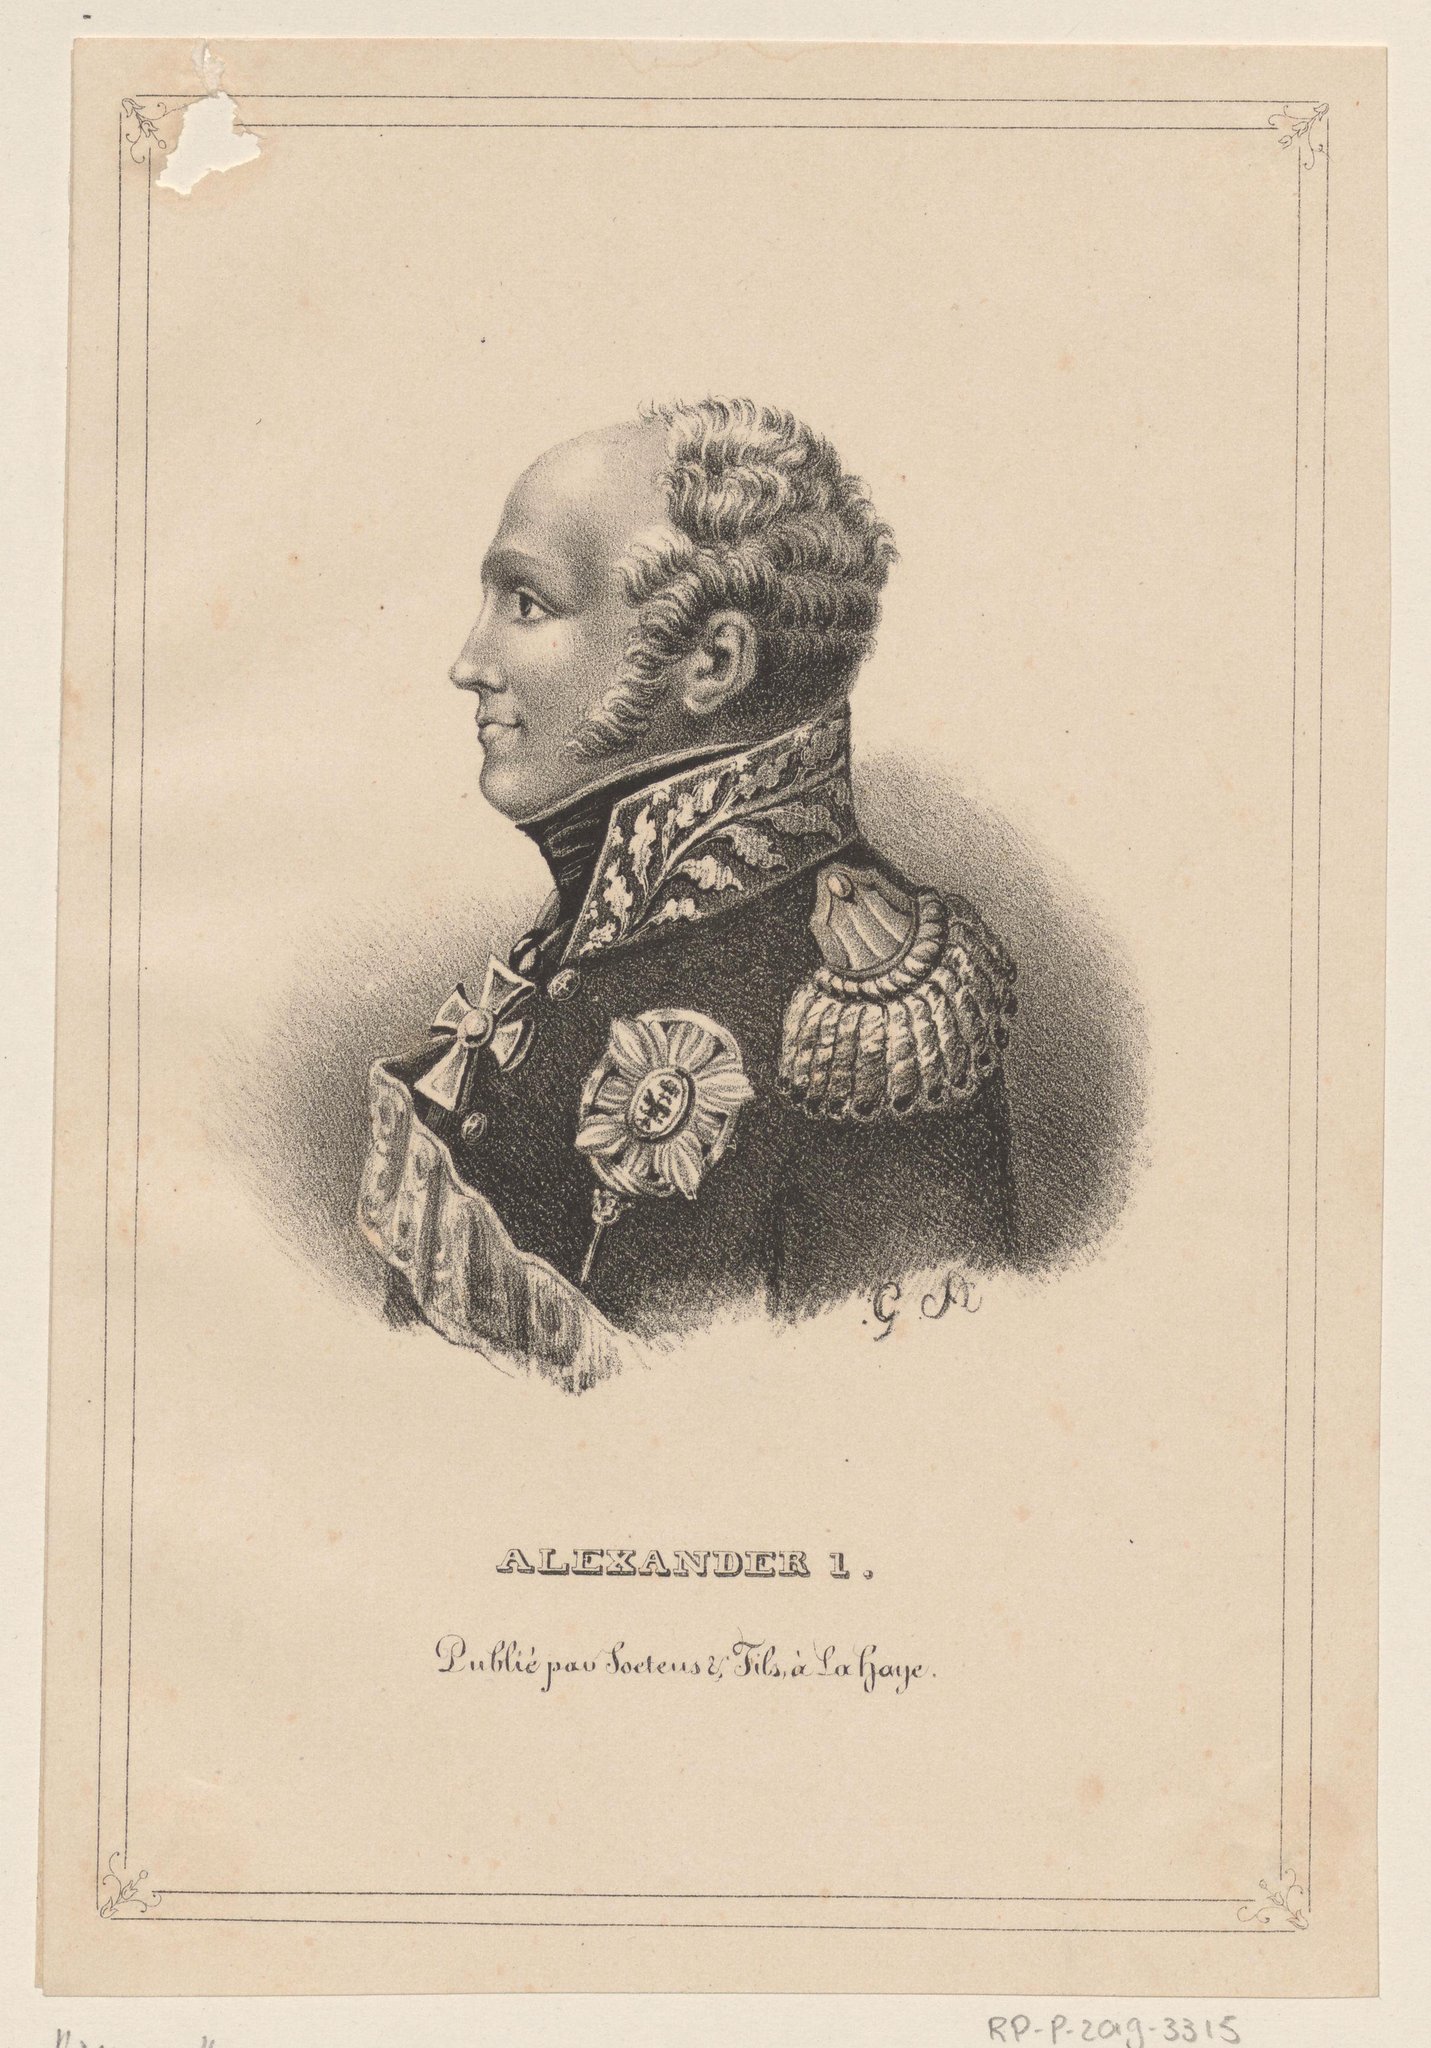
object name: print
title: Portret van Alexander I, tsaar van Rusland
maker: achille girardot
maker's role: draughtsman, painter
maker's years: 1814-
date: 1837-1840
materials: paper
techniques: lithograph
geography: the hague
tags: alexander i (tsaar van rusland), historical persons, emperor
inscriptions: collector's mark: Lugt 2228